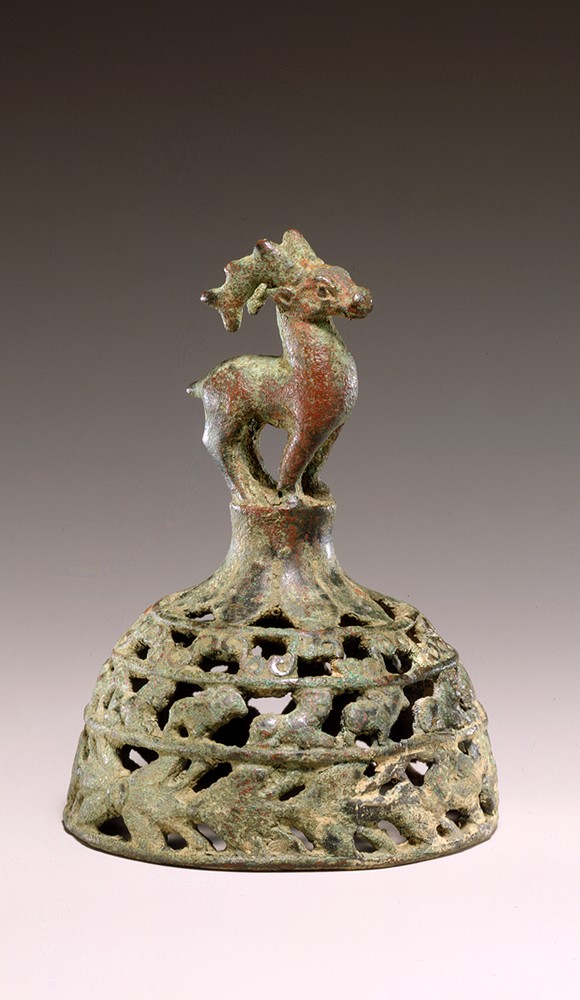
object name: incense burner lid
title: Incense Burner Lid with Stag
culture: pakistani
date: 100-1 BCE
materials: bronze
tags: deer